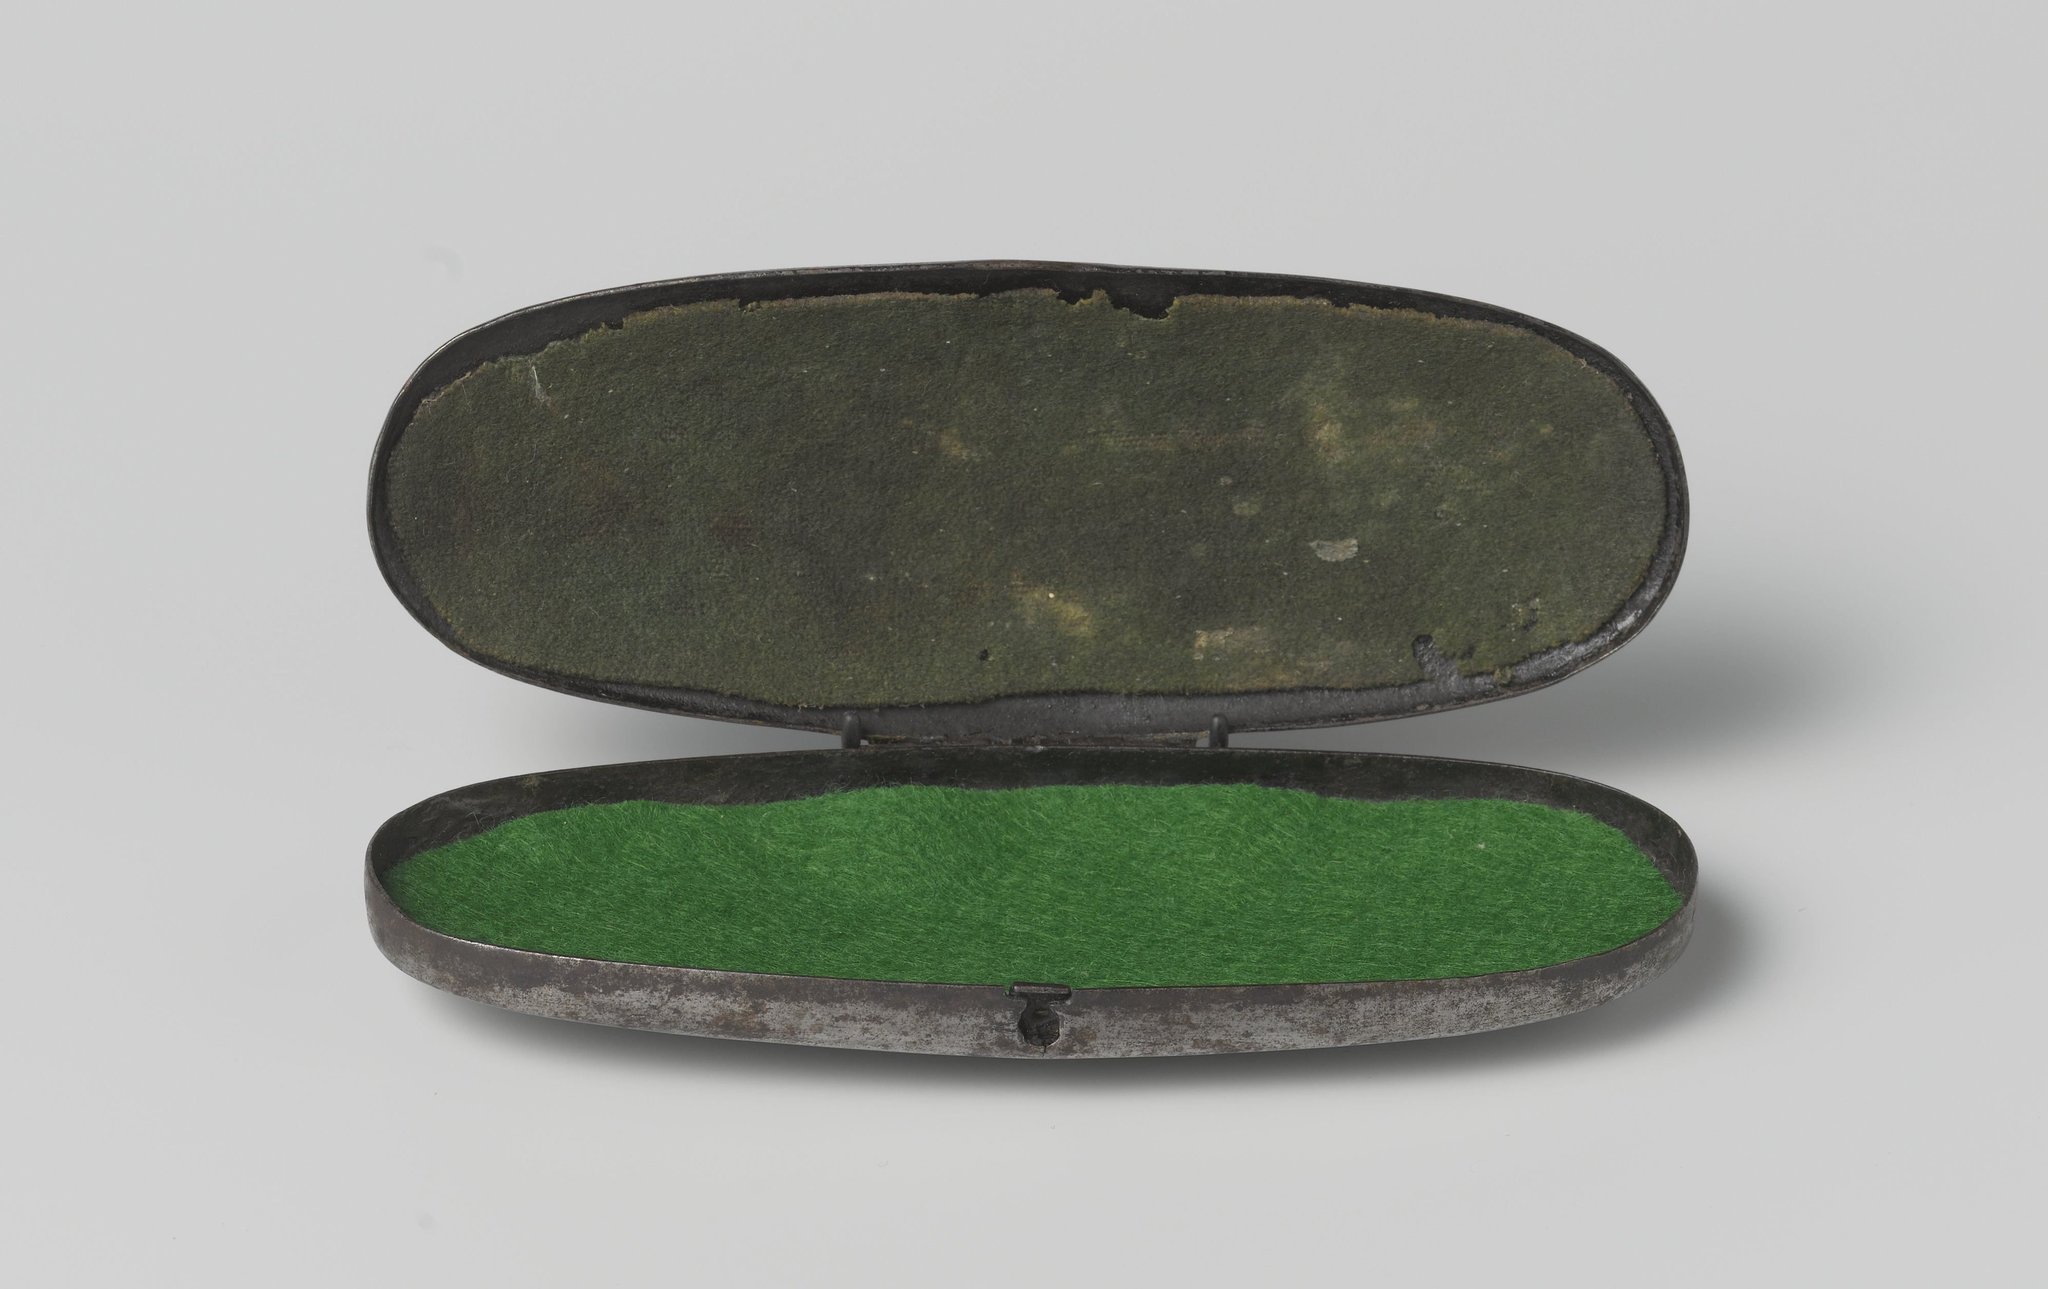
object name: brillendoos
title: Spectacle-case with spectacles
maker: Anonymous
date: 1890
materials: textile, iron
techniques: forging, weave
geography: england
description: Brillendoos van ijzer, gevoerd met groen laken. Ovale brillendoos met deksel.